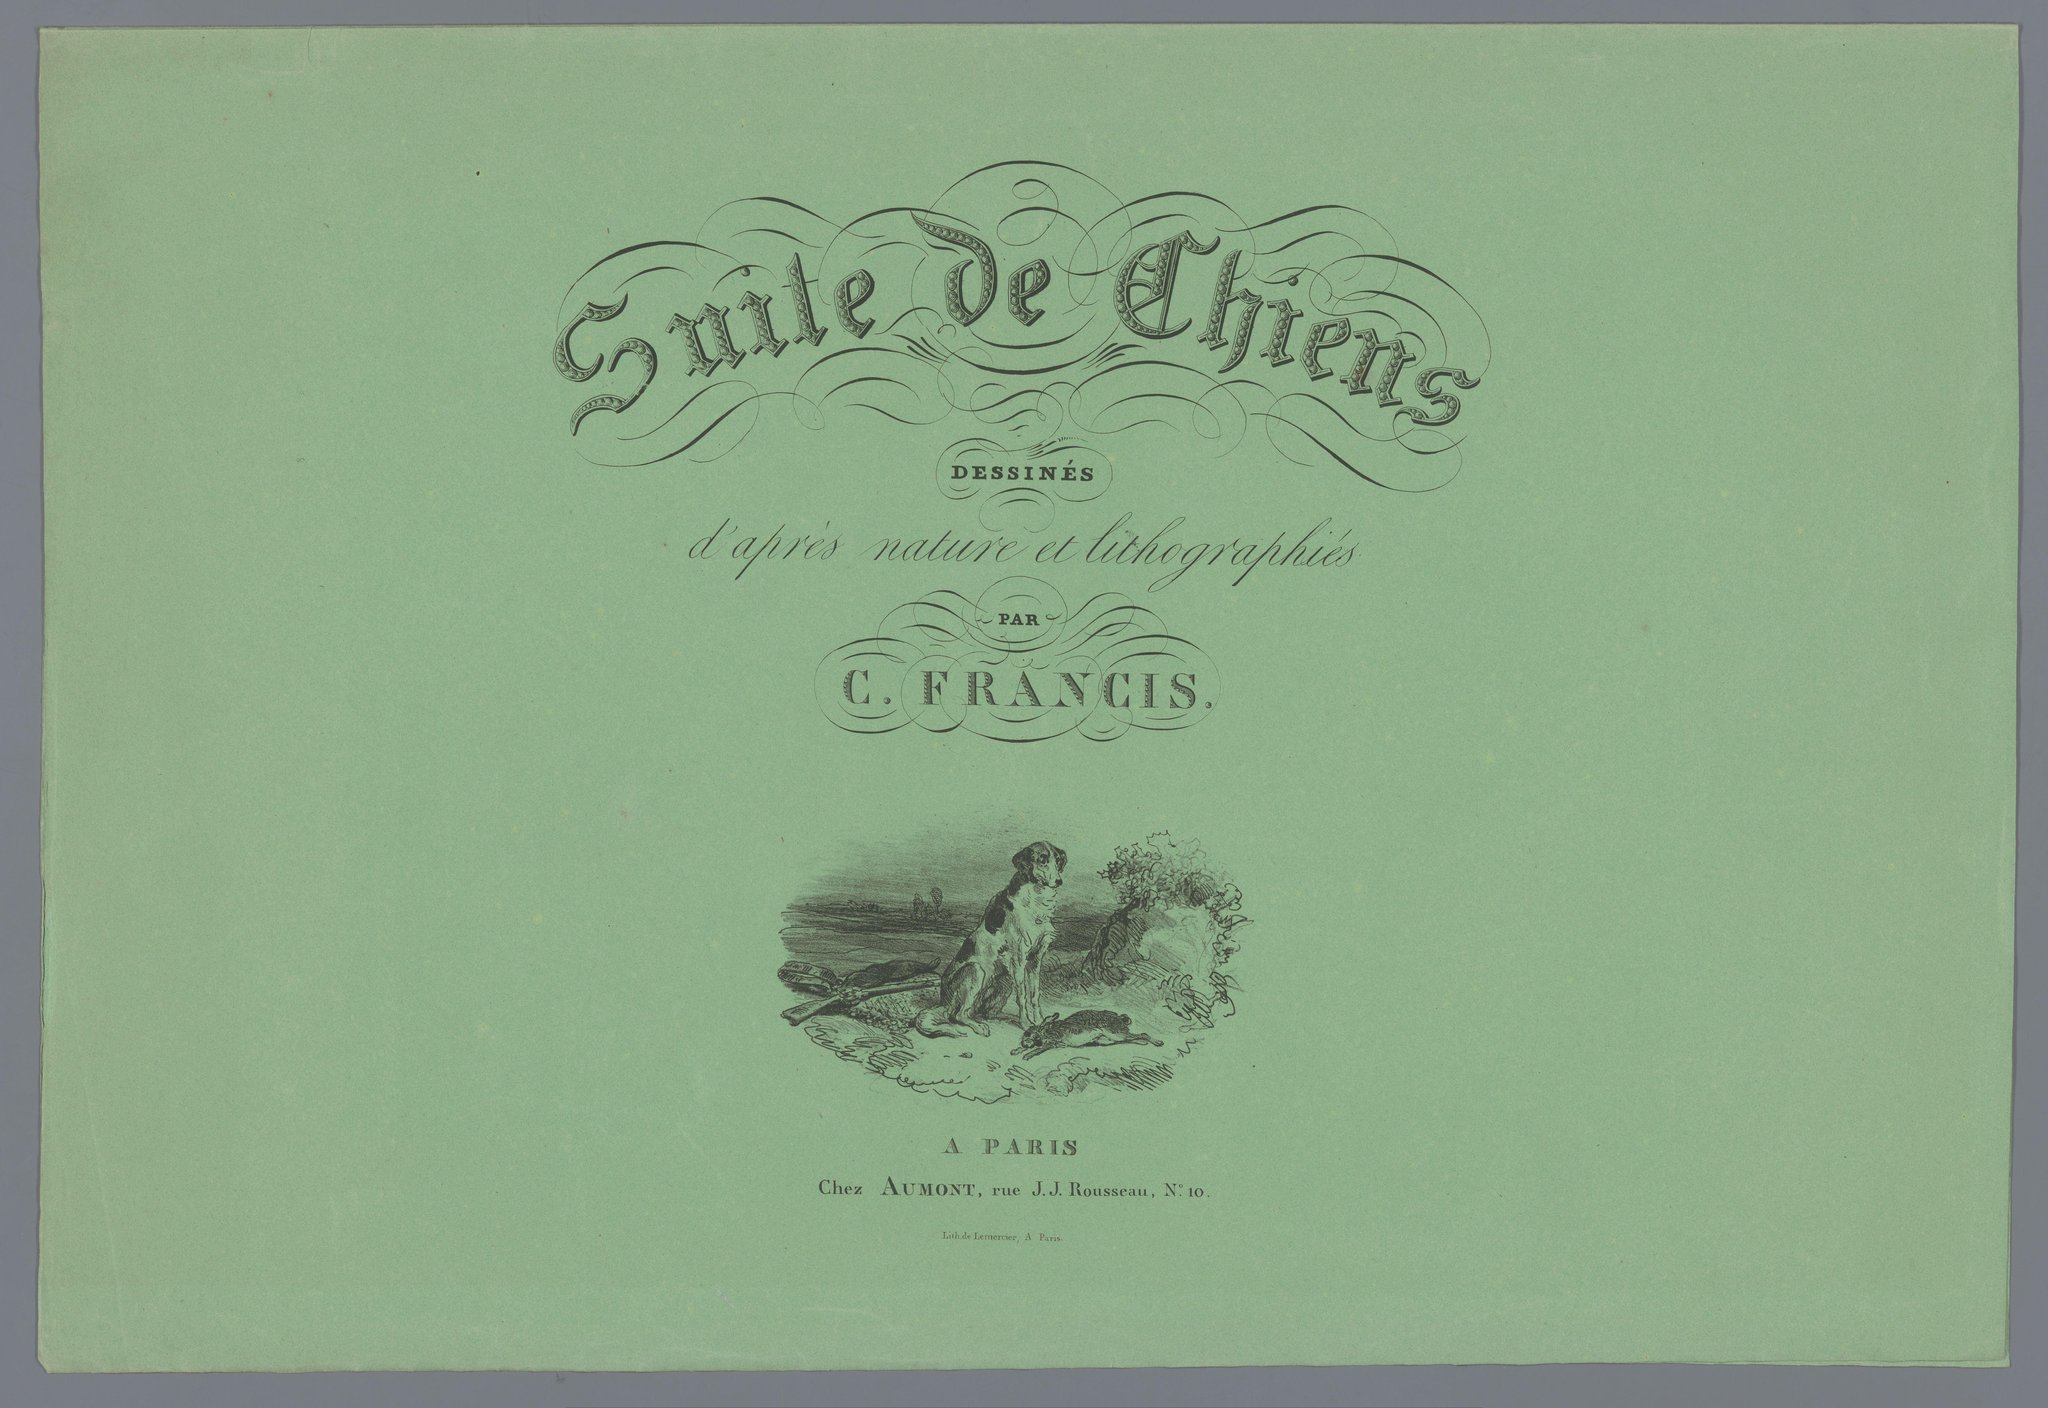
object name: wrapper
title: Jachthonden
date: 1837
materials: paper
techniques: lithograph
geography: paris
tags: hunting dogs, hare-hunting, rabbit-hunting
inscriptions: collector's mark: Lugt 2228a